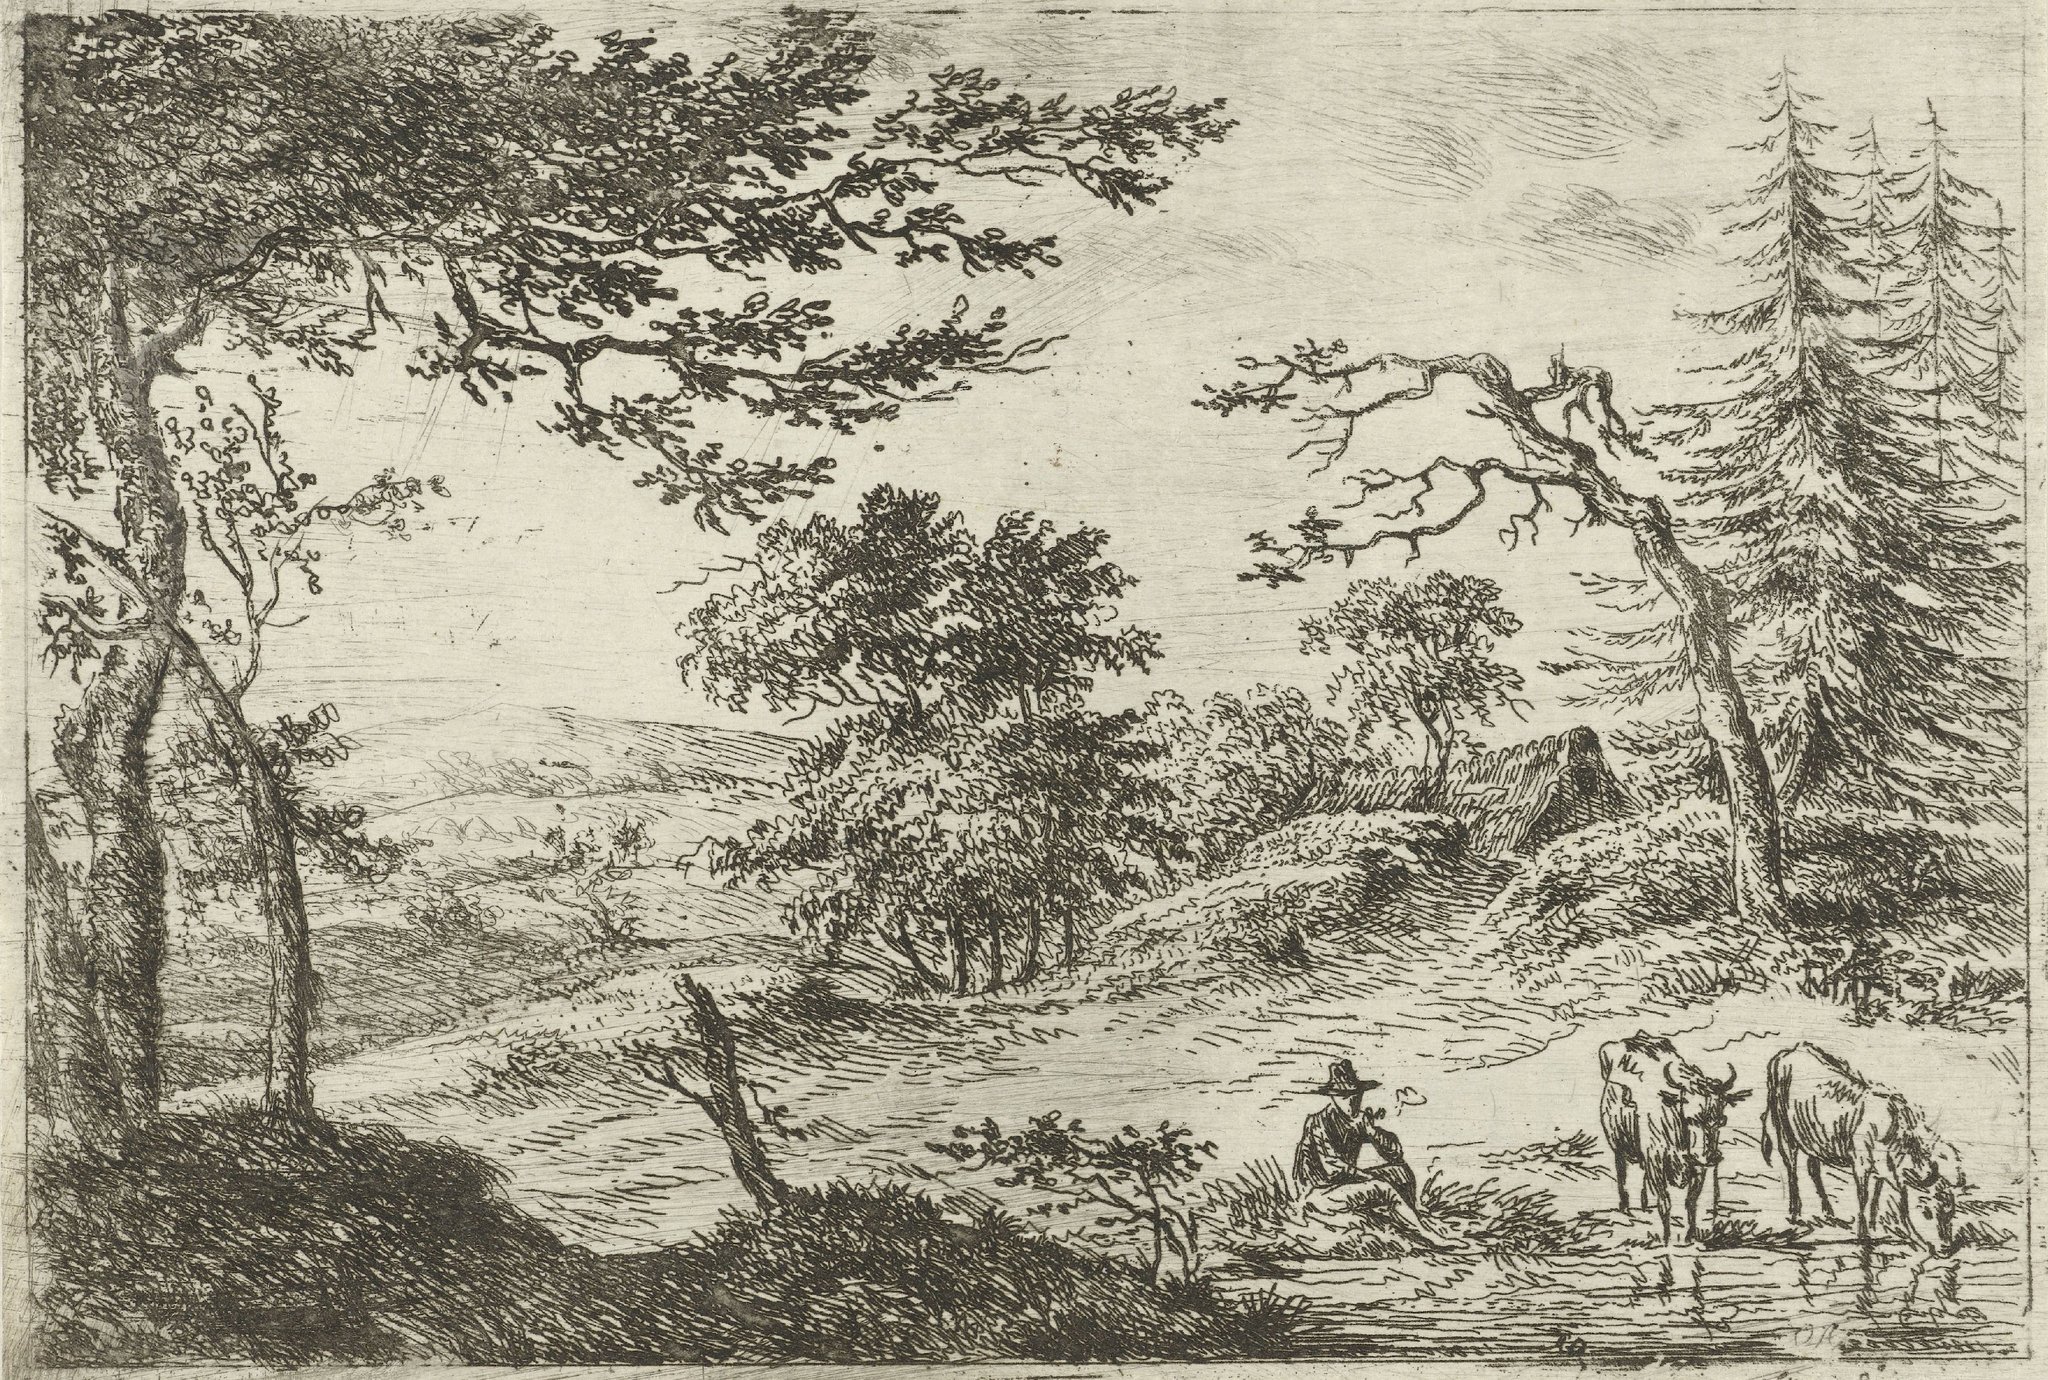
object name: print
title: Landschap met herder en twee koeien bij een waterplas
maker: anthony oberman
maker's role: draughtsman, painter, print maker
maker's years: 1781-1845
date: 1796-1845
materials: paper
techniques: etching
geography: amsterdam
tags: cow, herding, herdsman, herdswoman, shepherd, shepherdess, cowherd, etc.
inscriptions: collector's mark: Lugt 2228